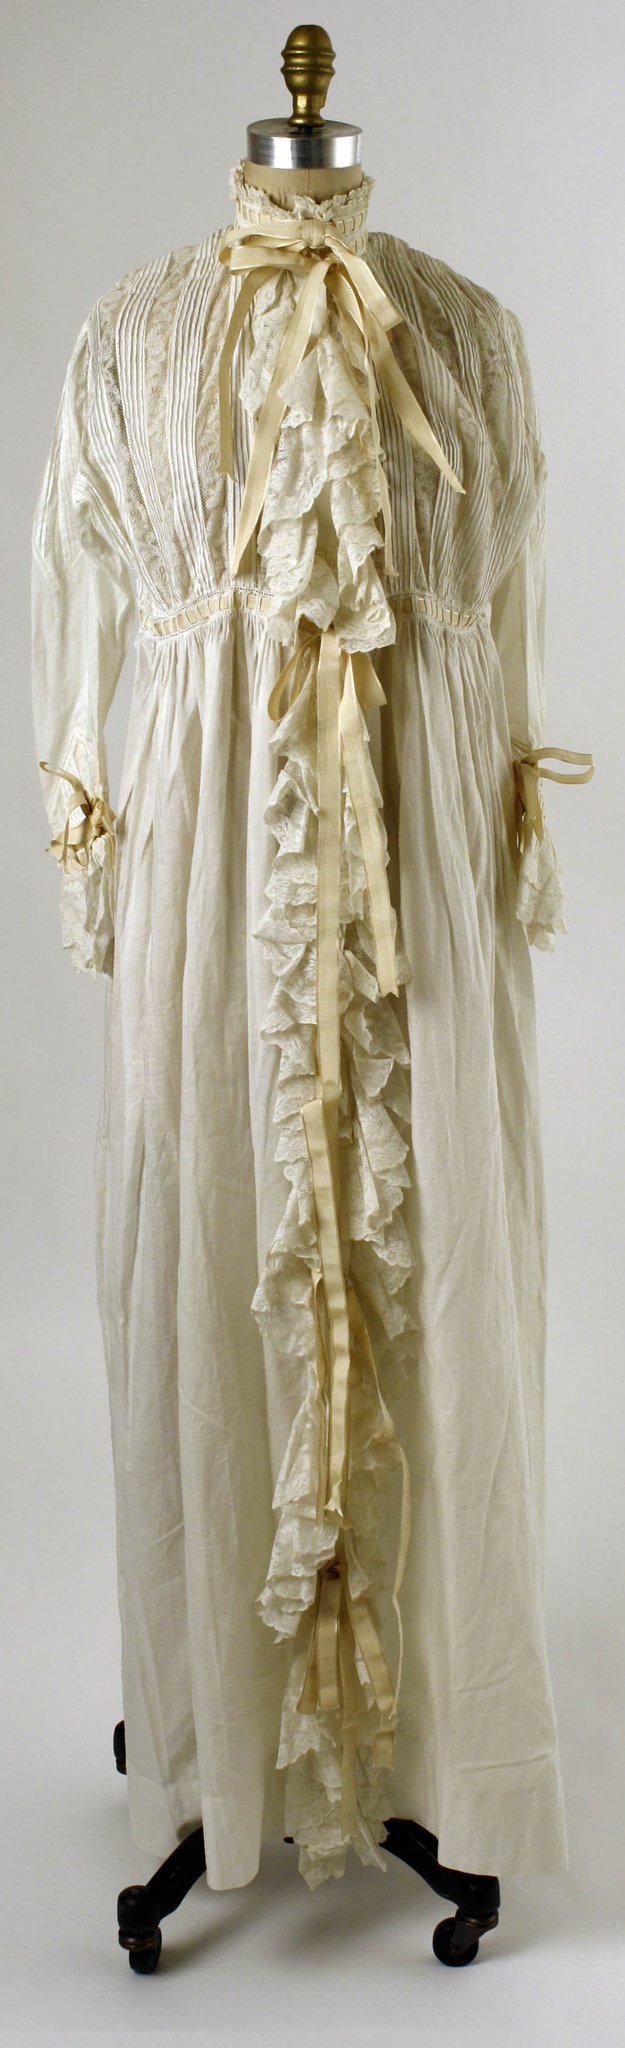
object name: nightgown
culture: american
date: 1880-1889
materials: cotton, silk